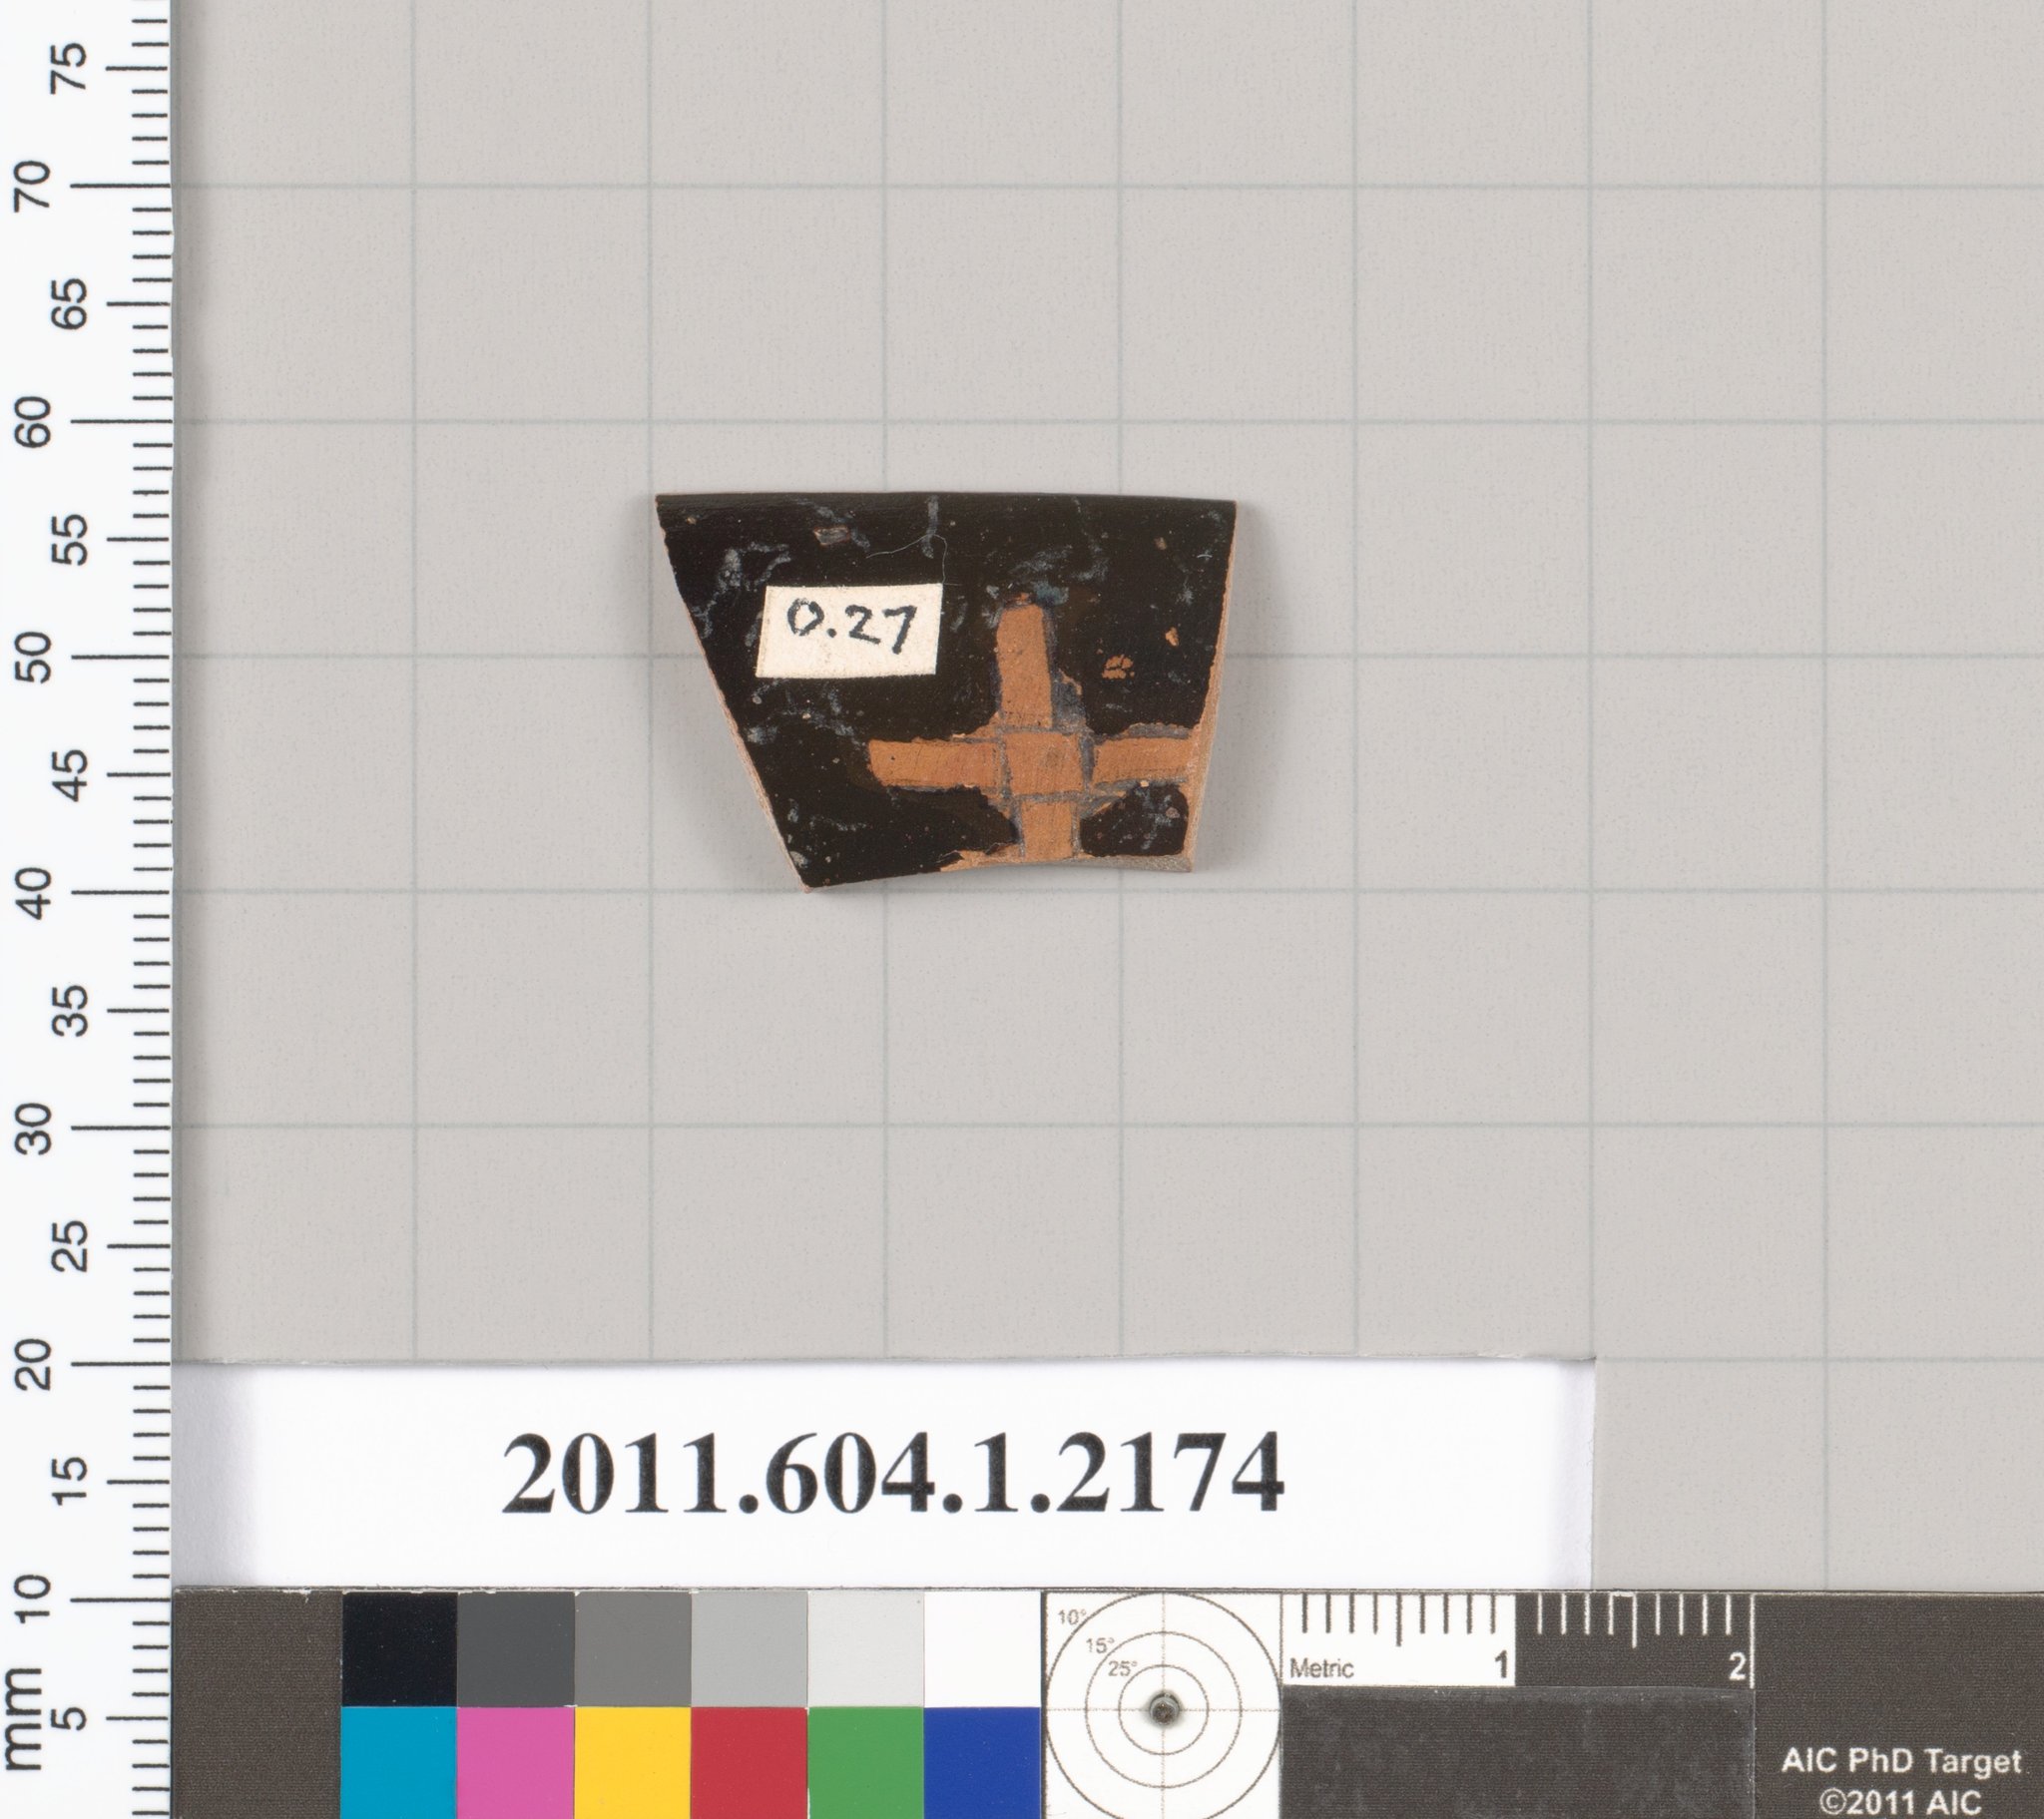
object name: kylix fragment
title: Terracotta rim fragment of a kylix (drinking cup)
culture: greek, attic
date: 475-451 BCE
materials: terracotta